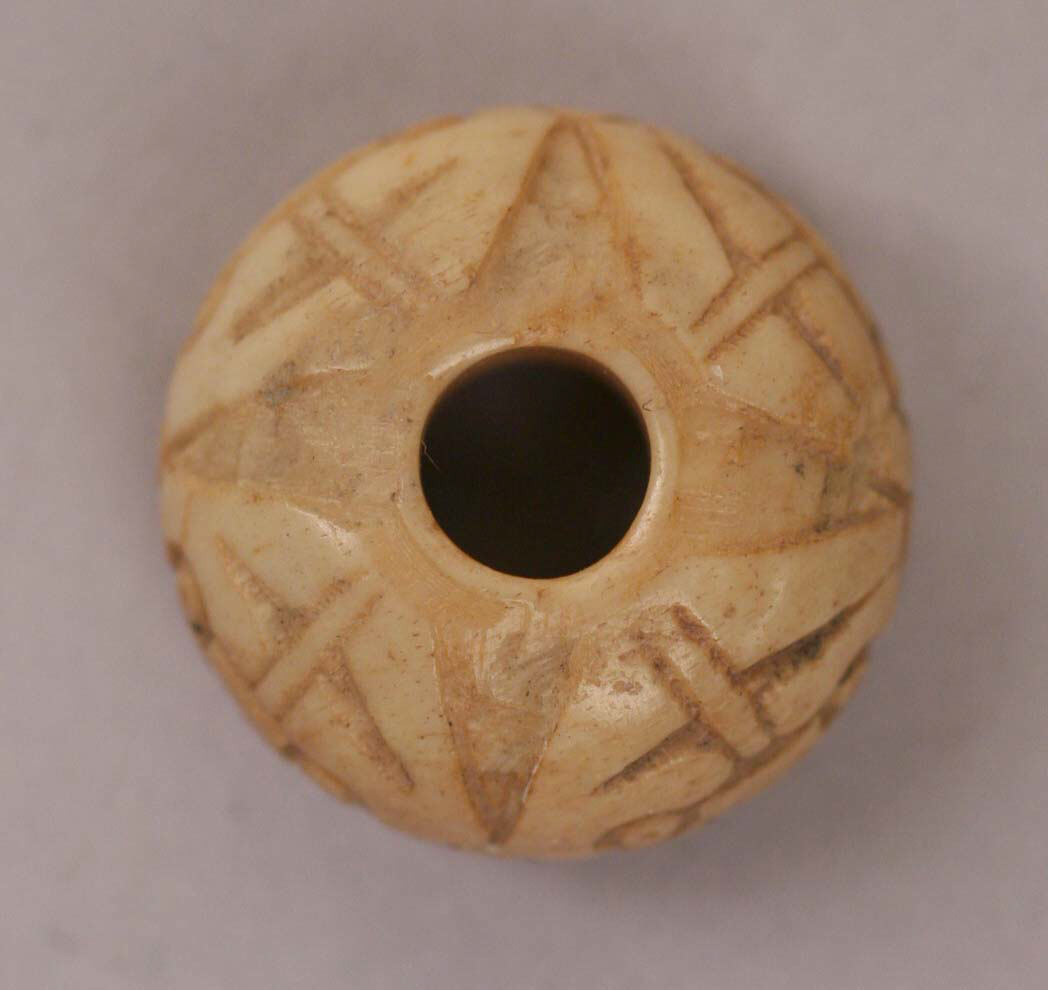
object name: button or bead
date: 801-1000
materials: bone, paint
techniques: incising, inlay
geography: iran